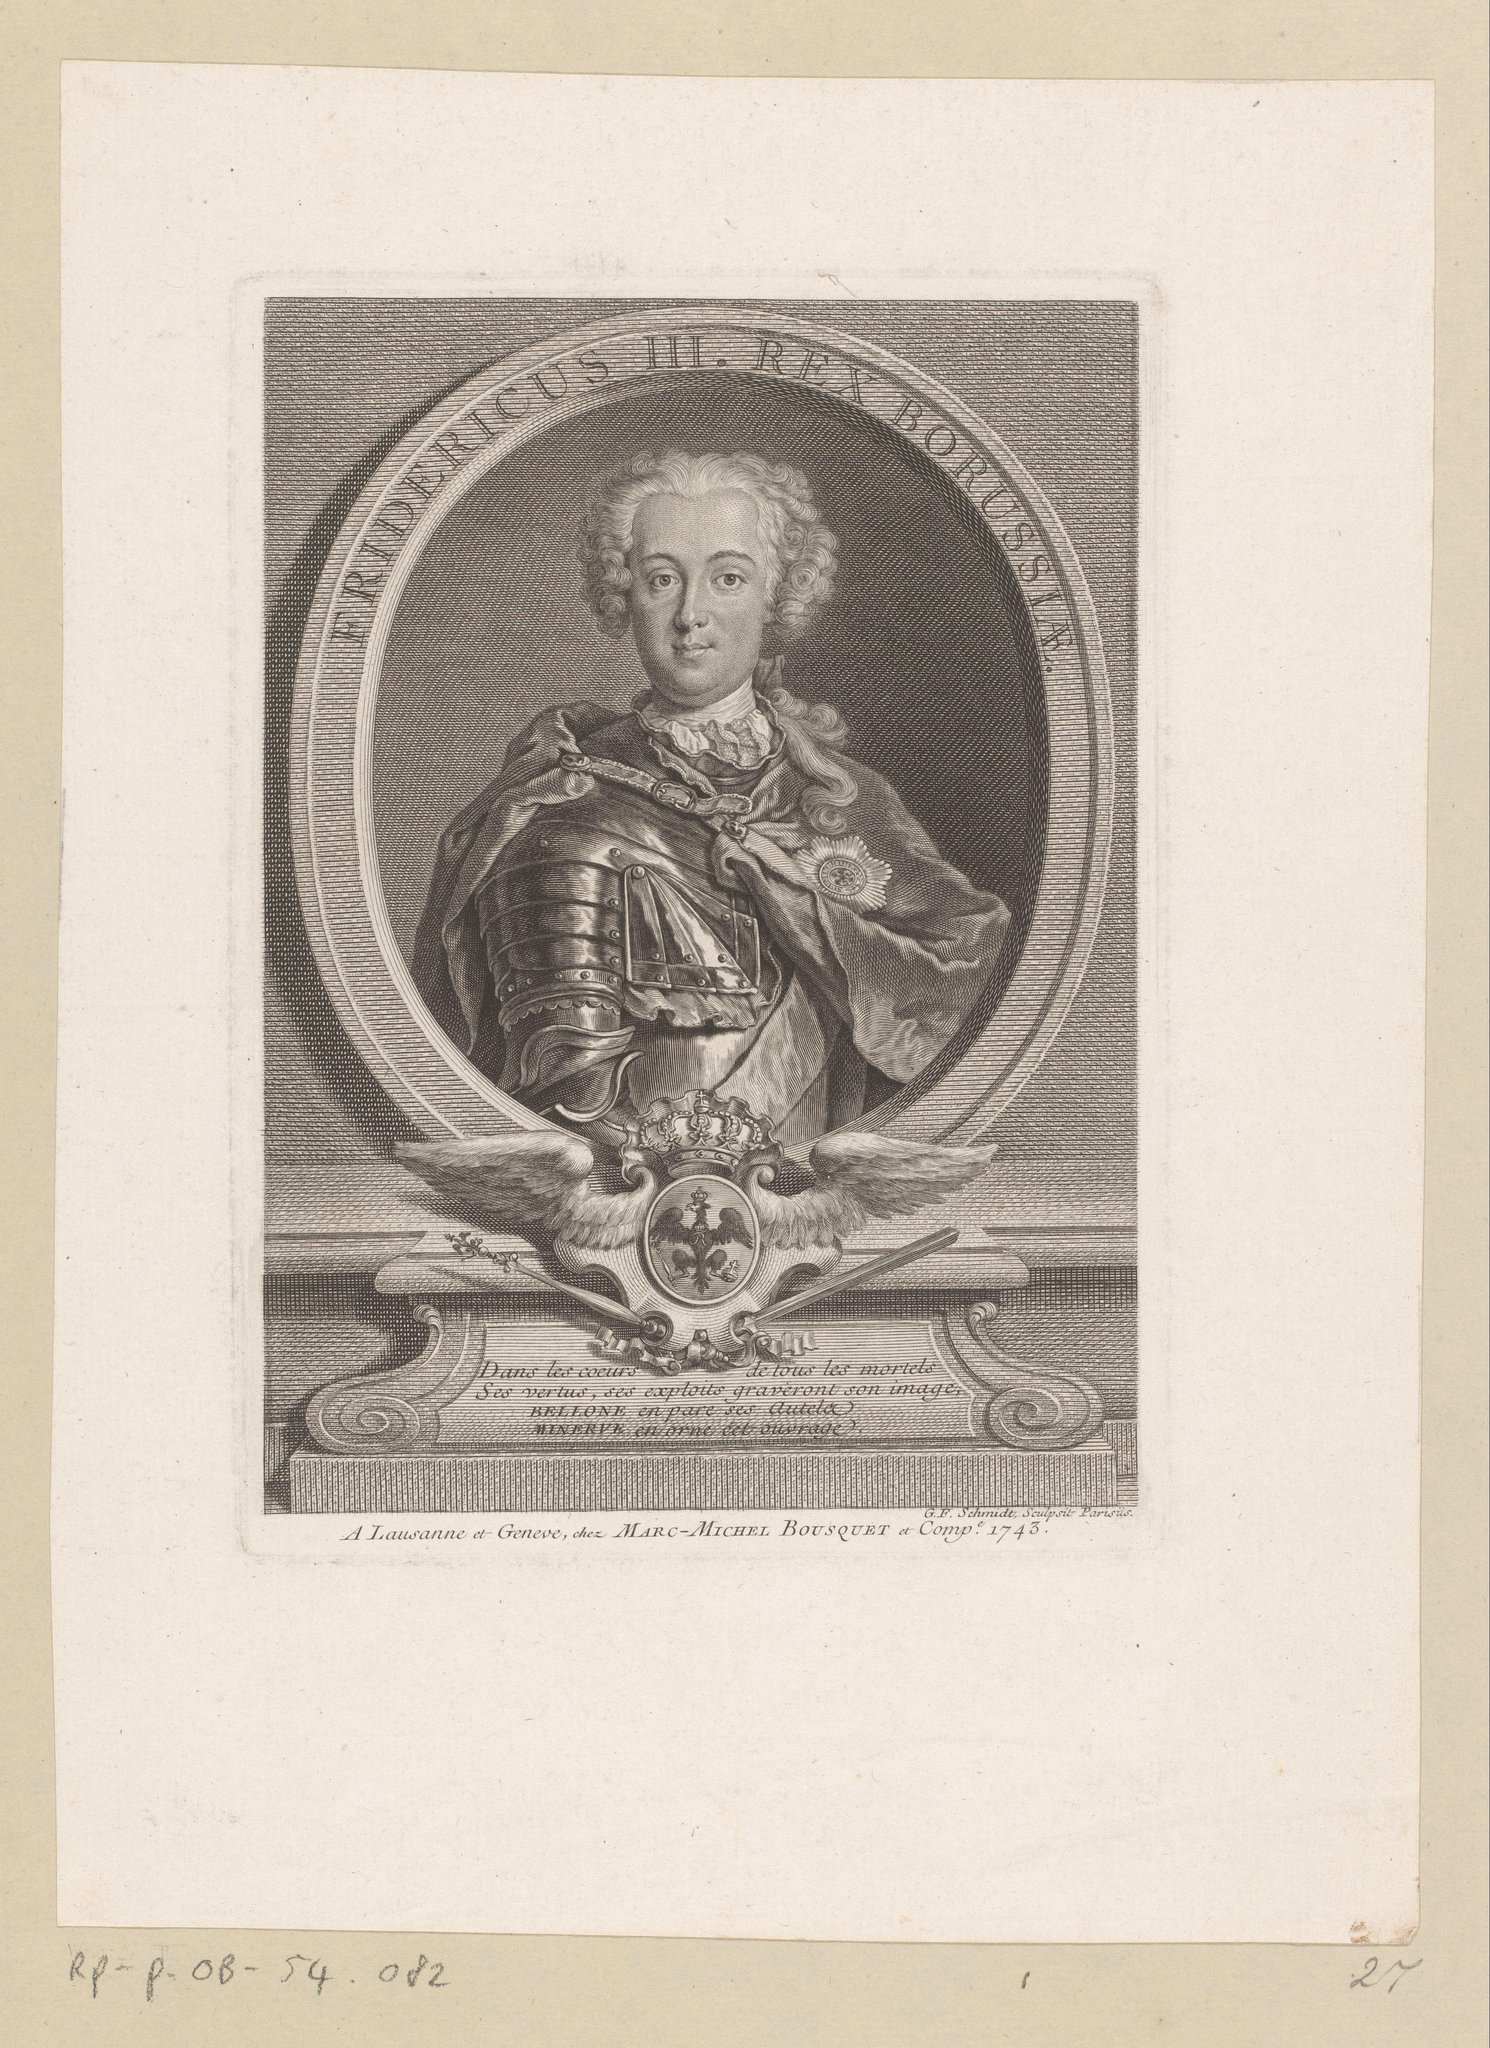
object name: print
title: Portret van Frederik de Grote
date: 1743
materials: paper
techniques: engraving, etching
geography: lausanne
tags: berlin, frederick ii (king of prussia), historical persons, armorial bearing, heraldry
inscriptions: collector's mark: Lugt 240